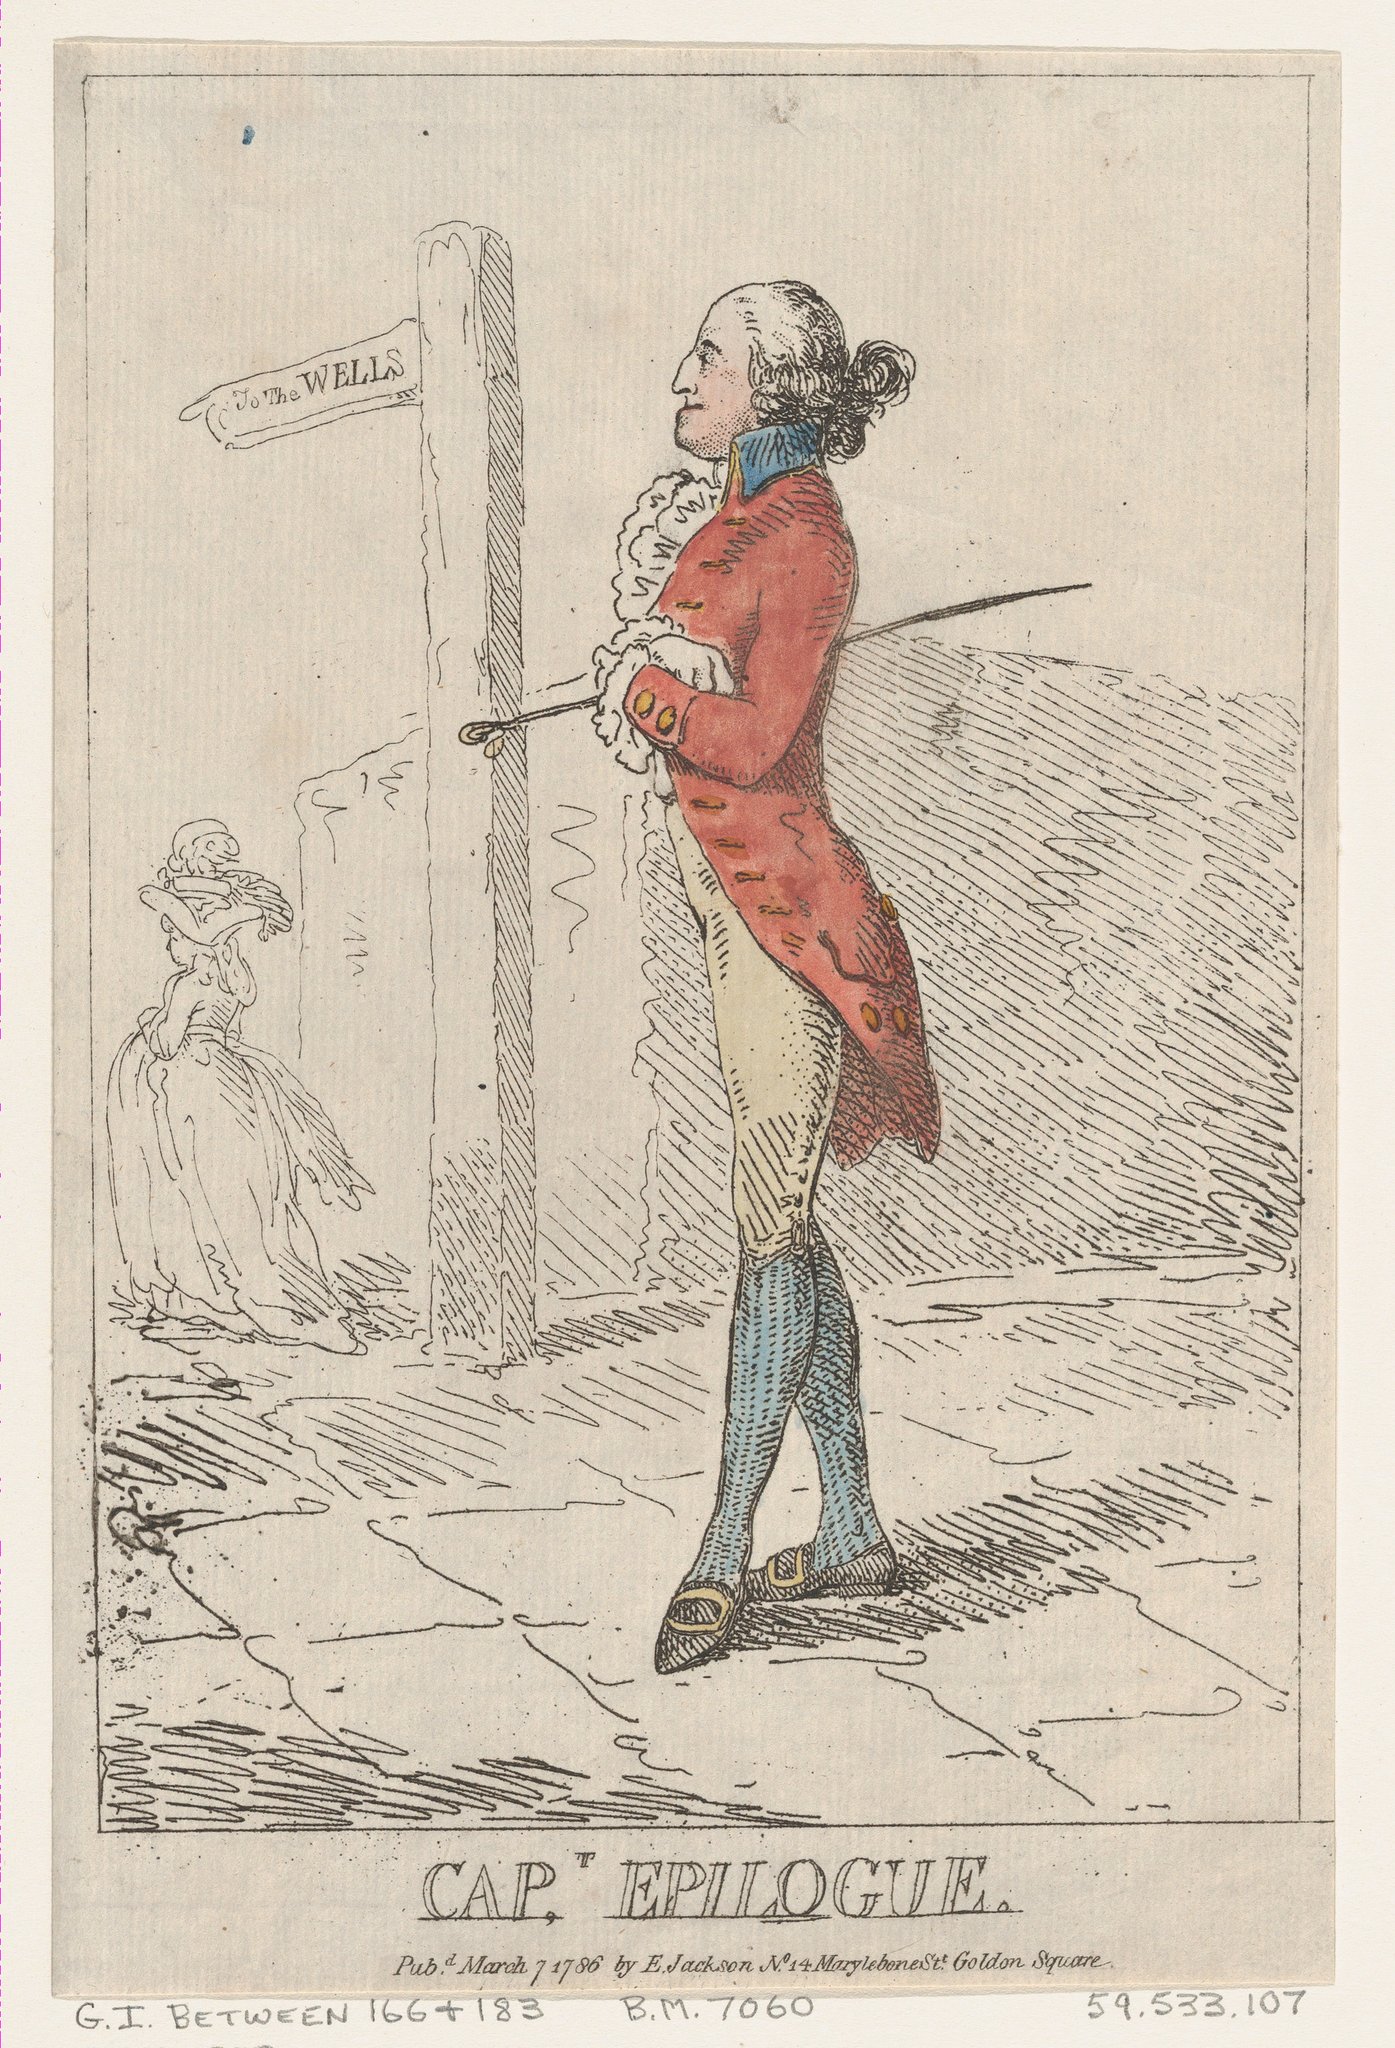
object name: print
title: Captain Epilogue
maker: thomas rowlandson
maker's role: artist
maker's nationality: british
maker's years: 1757-1827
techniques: etching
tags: men